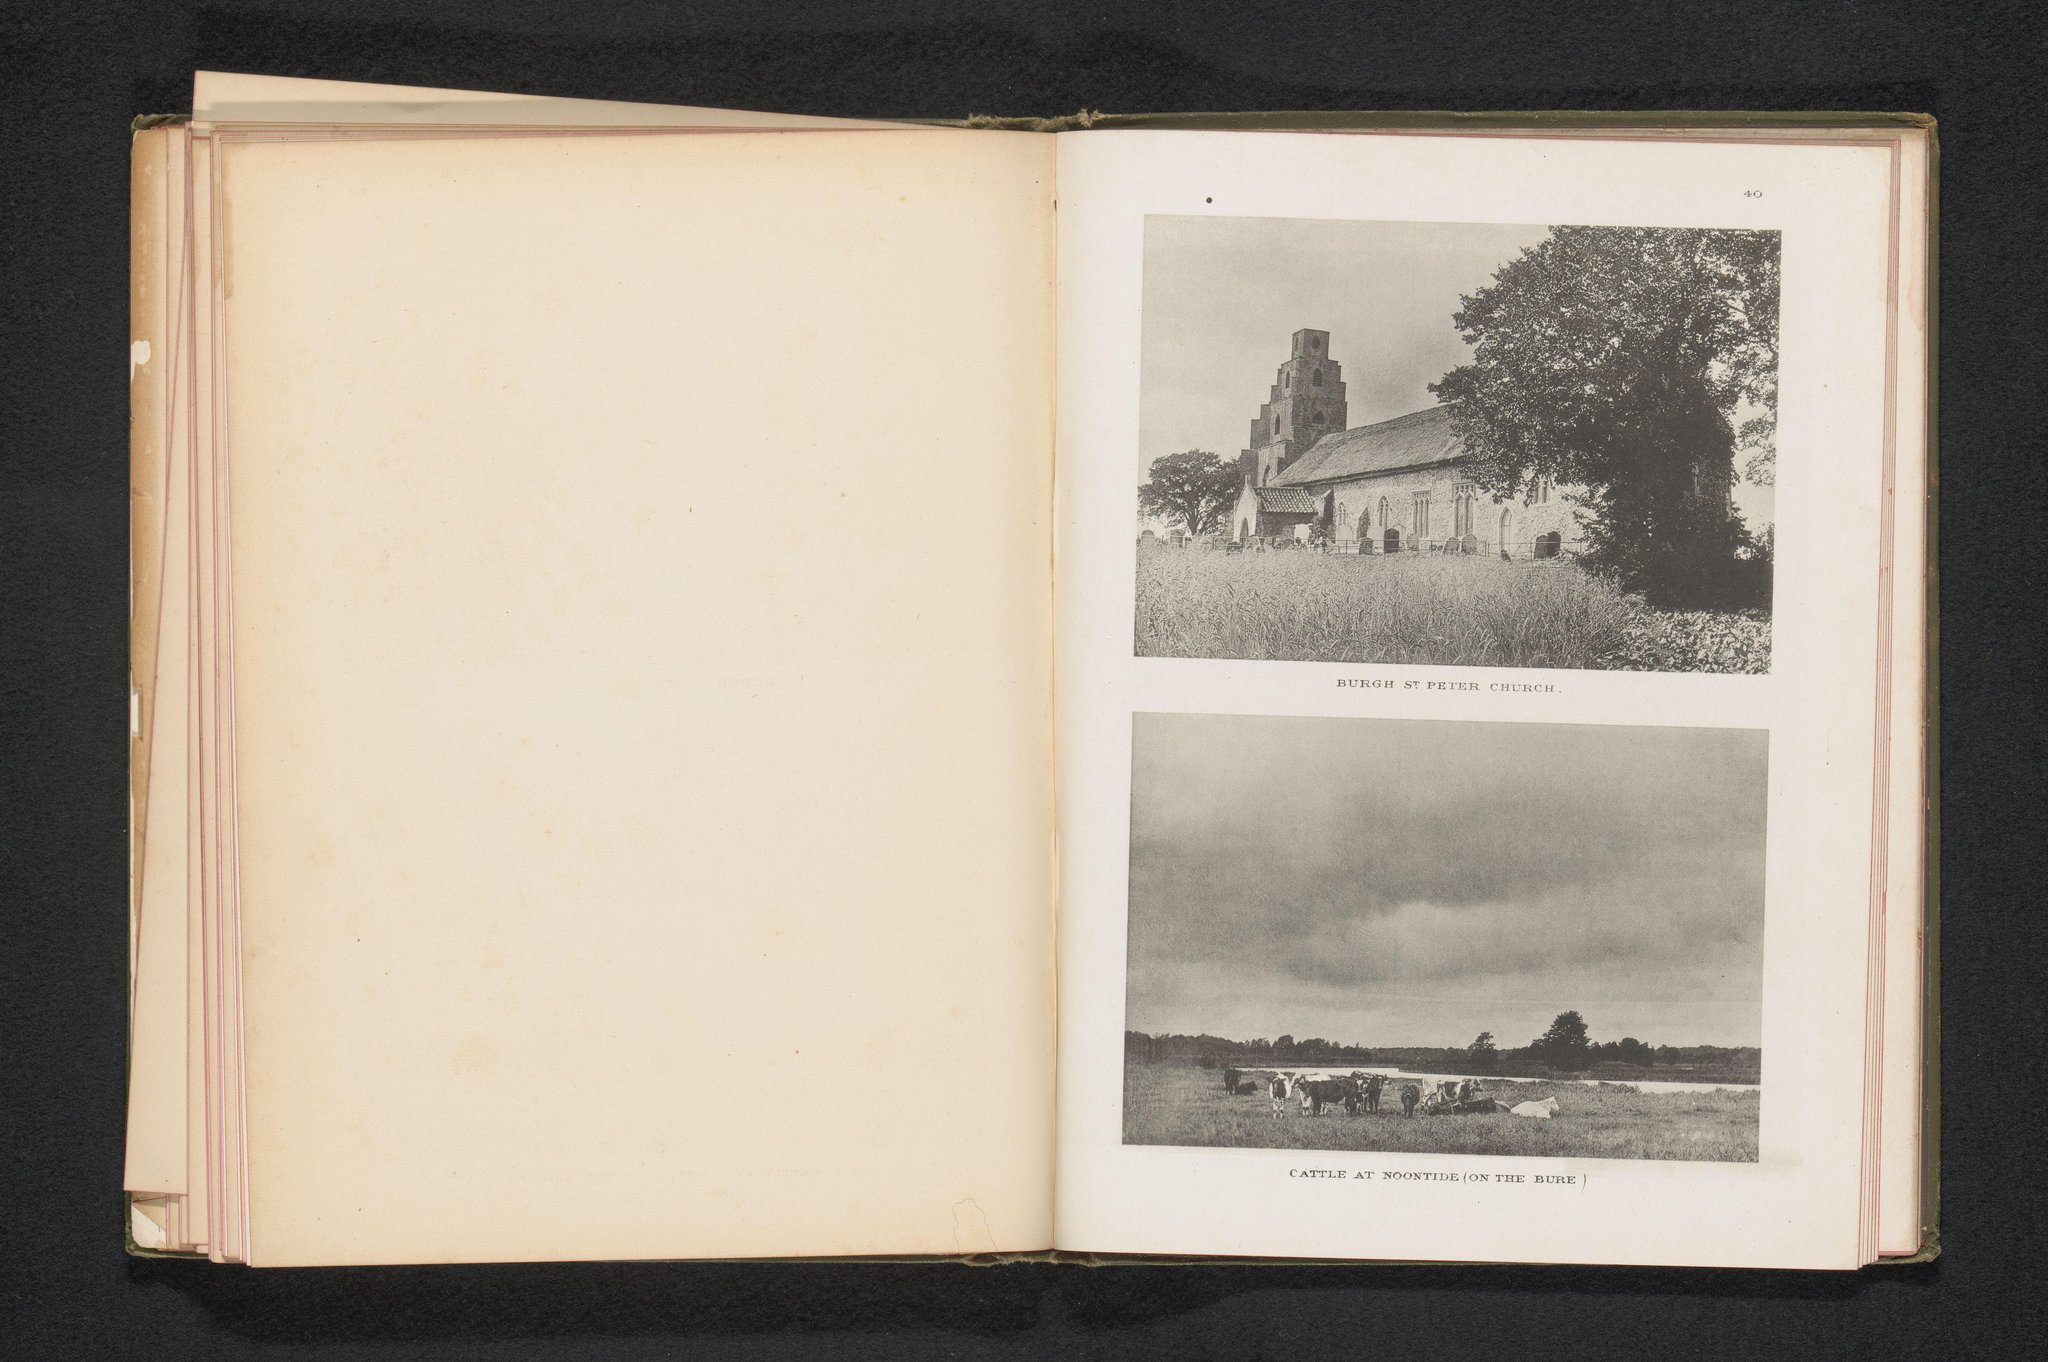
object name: page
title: Grazende koeien langs de Bure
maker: john payne jennings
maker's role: fotograaf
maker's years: 1843-1926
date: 1886-1891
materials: paper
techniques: photograph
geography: norfolk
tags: cow, river